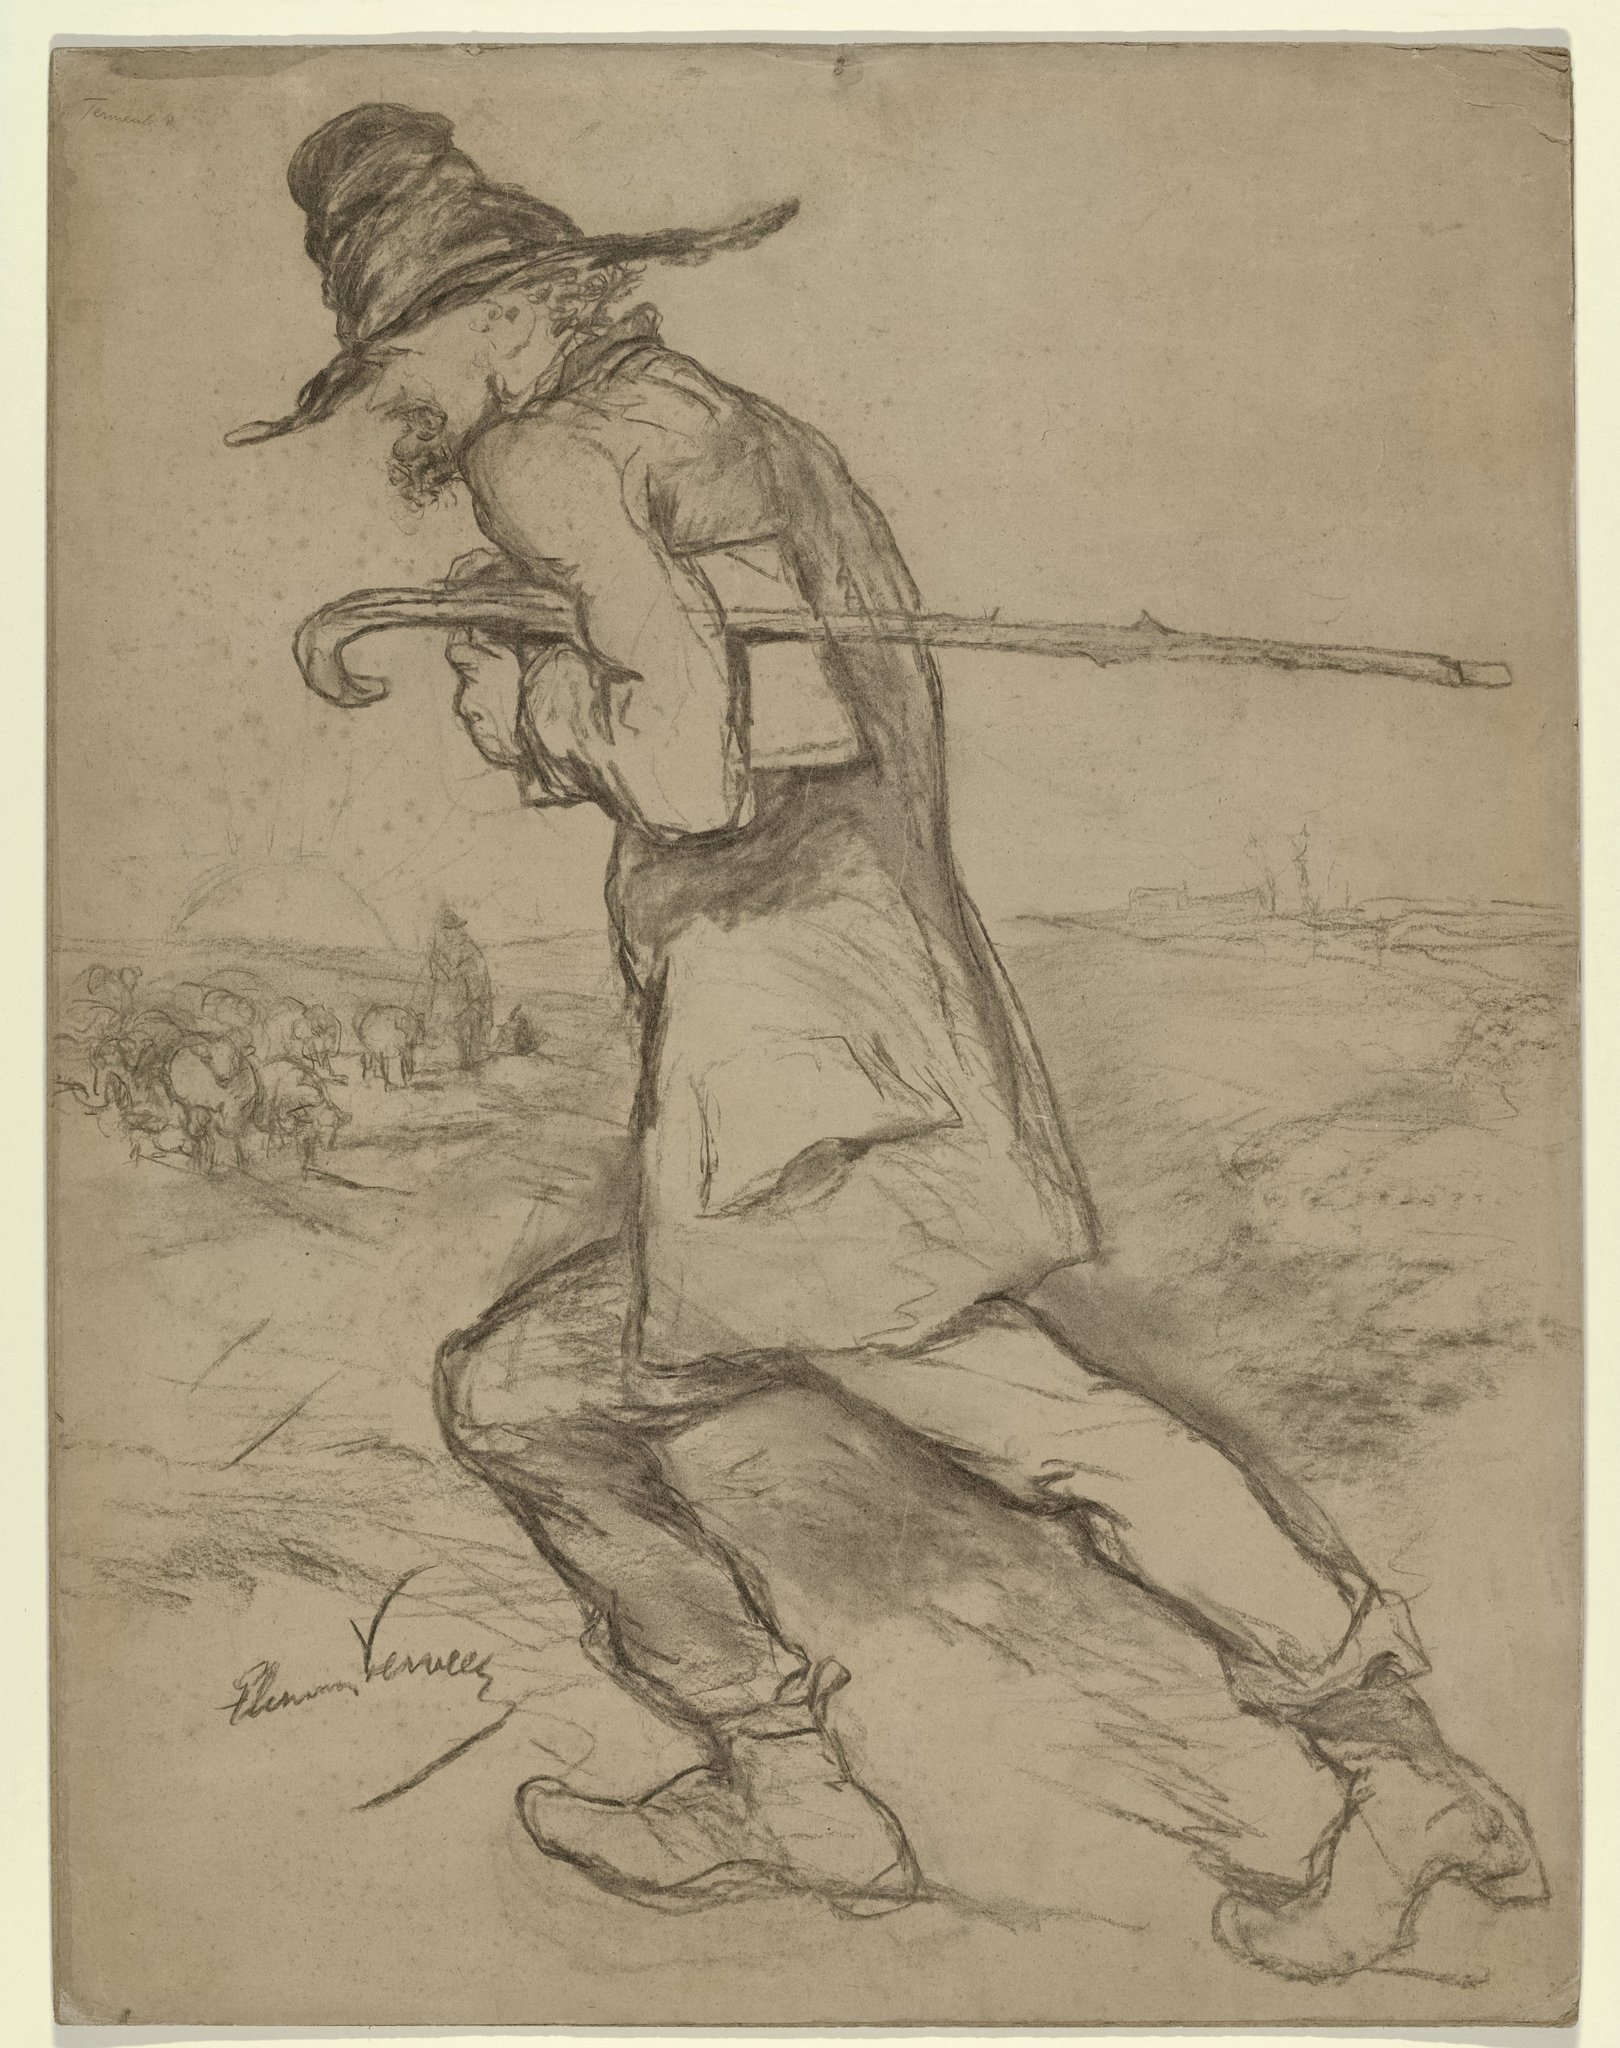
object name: caricature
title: Karikatuurportret van Francois Pieter ter Meulen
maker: elchanon verveer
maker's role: draughtsman, print maker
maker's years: 1826-1900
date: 1860-1899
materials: charcoal, paper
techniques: stumping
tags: bodegraven, the hague, painter, françois pieter ter meulen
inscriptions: signature: ‘Elchanon Verveer’, inscription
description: Karikatuurportret van de kunstschilder Francois Pieter ter Meulen (1843-1927), met zijn tekenportefeuille onder de arm het landschap in wandelend in de richting van zijn gebruikelijke onderwerp: een kudde schapen.